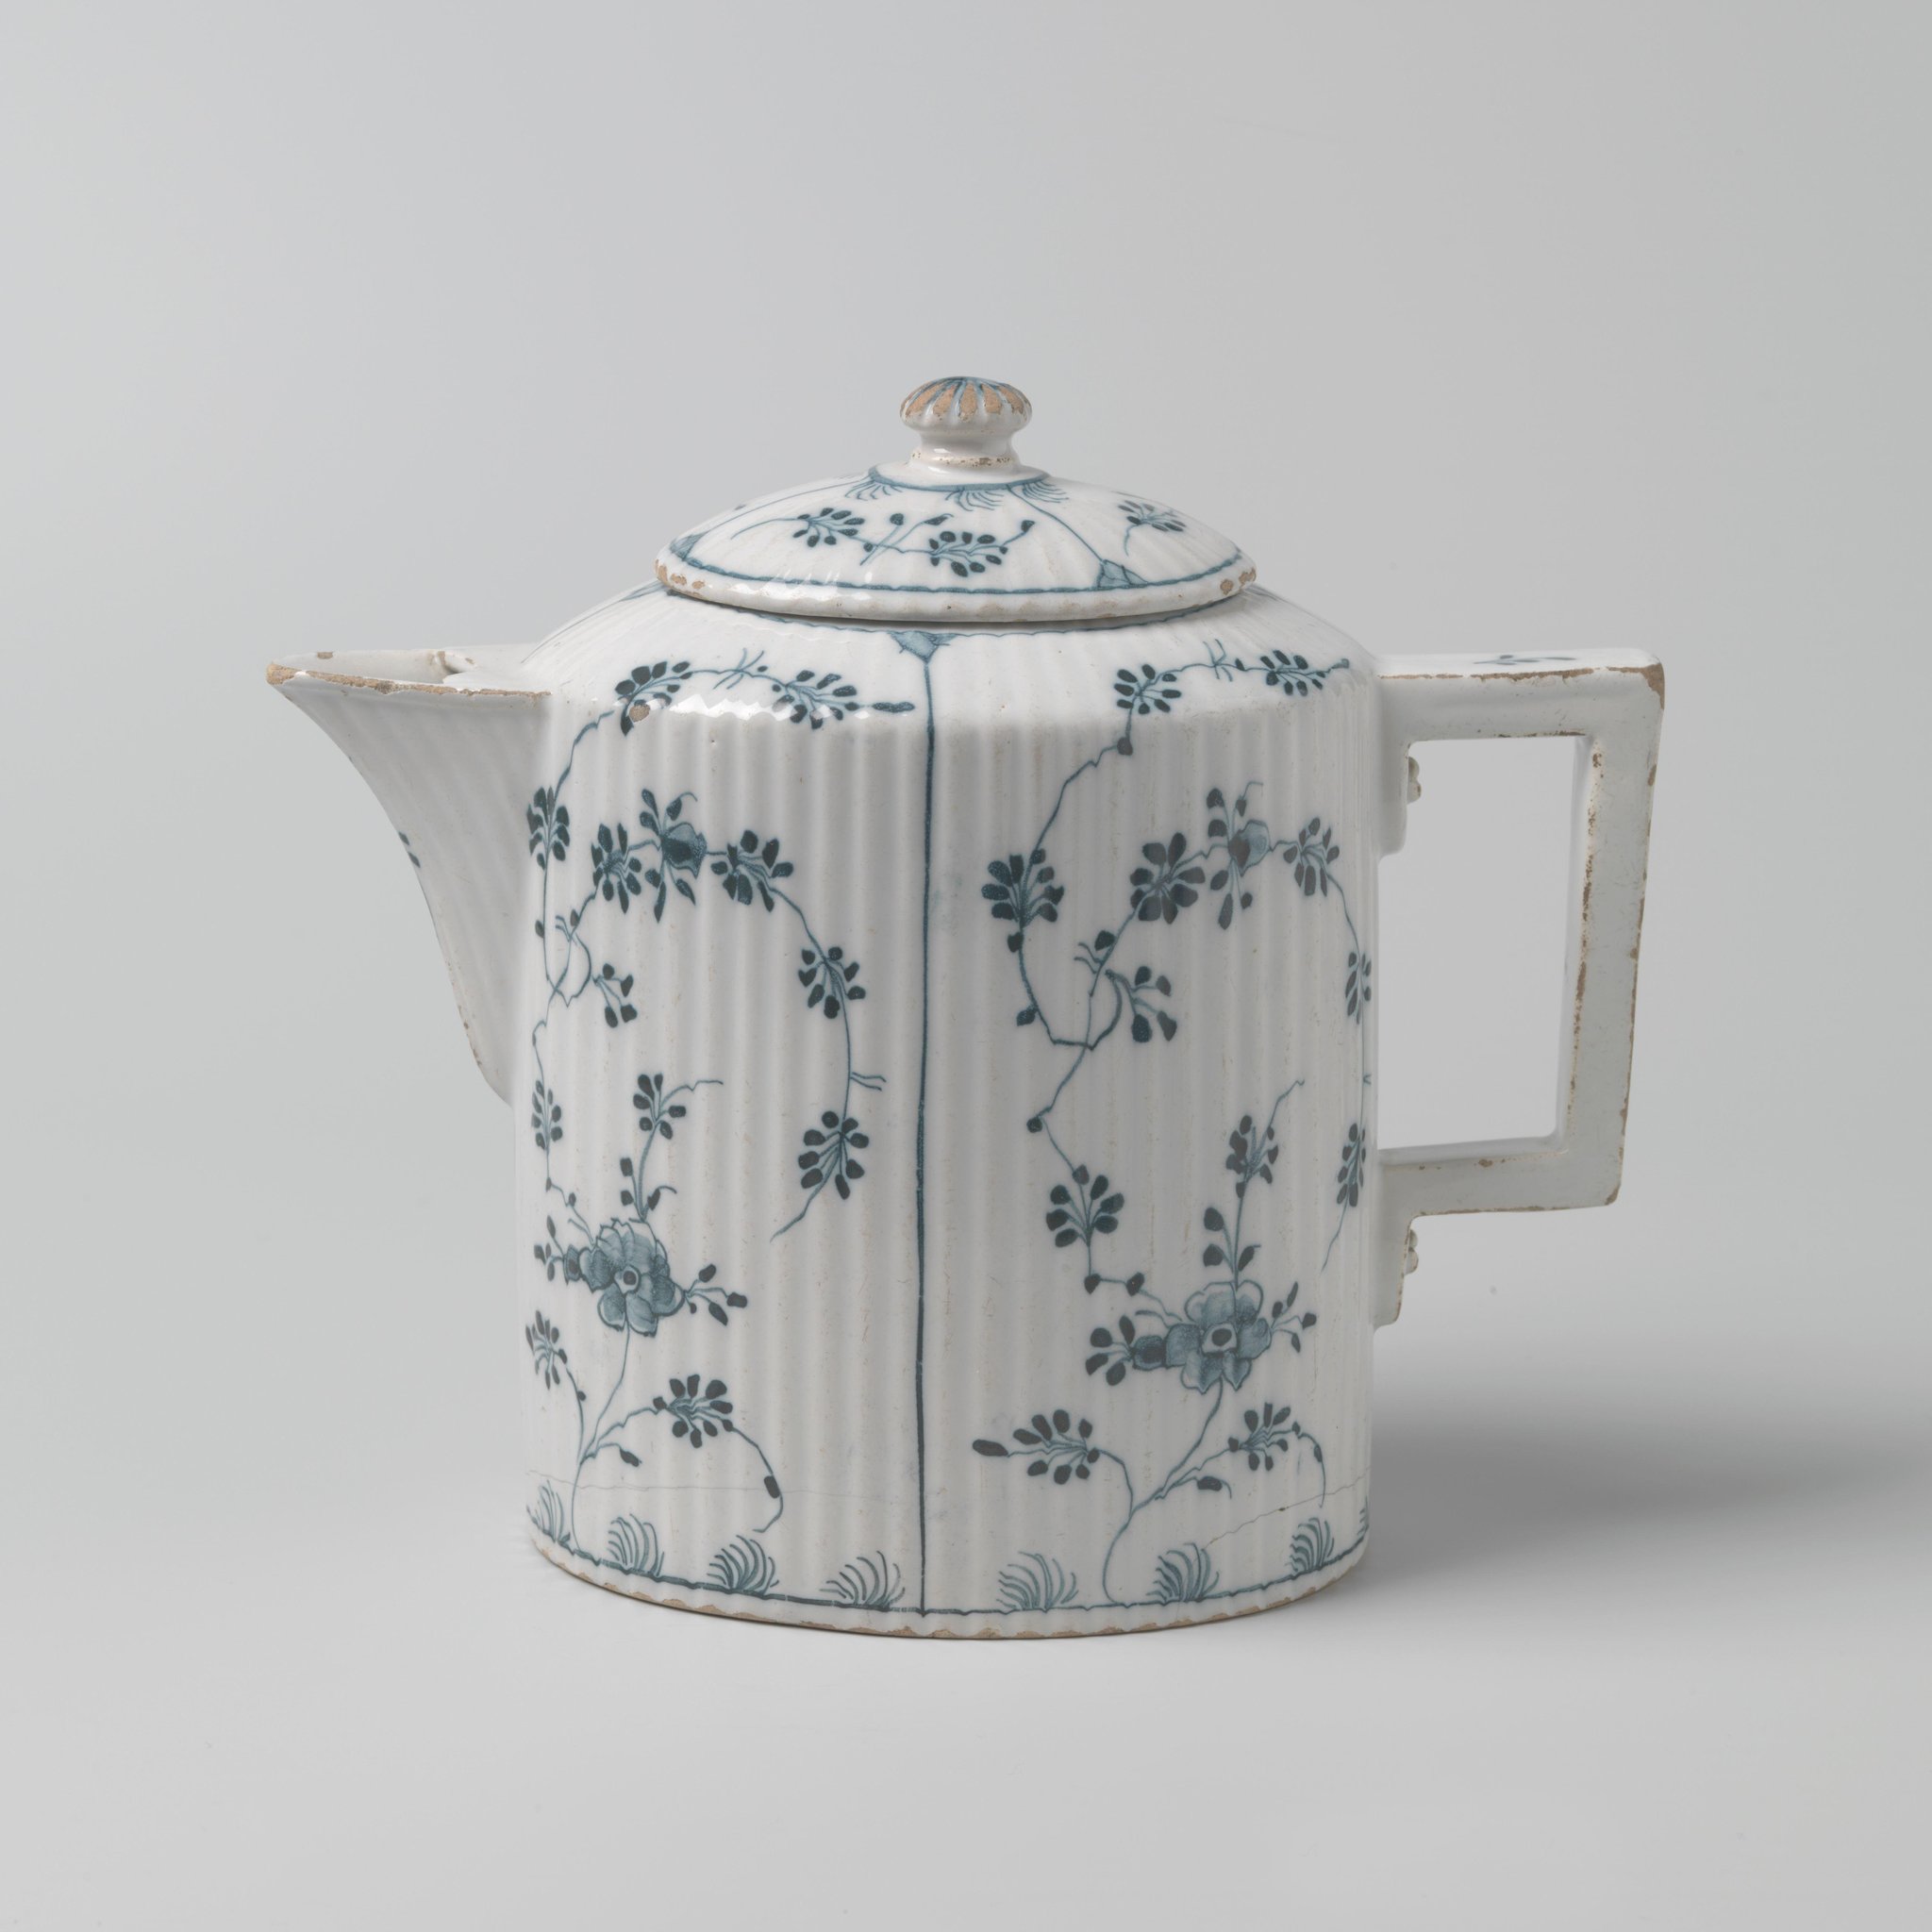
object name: coffee pot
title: Koffiekan, beschilderd met bloemenranken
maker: Anonymous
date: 1780-1830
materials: earthenware, glaze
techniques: painted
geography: germany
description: Ovale, cilindrische, geribde koffiepot van blauw beschilderde faience met een rechthoekig oor en een gedeukte sneb. Op de koffiepot zijn bloemenranken geschilderd. De pot is gemerkt.